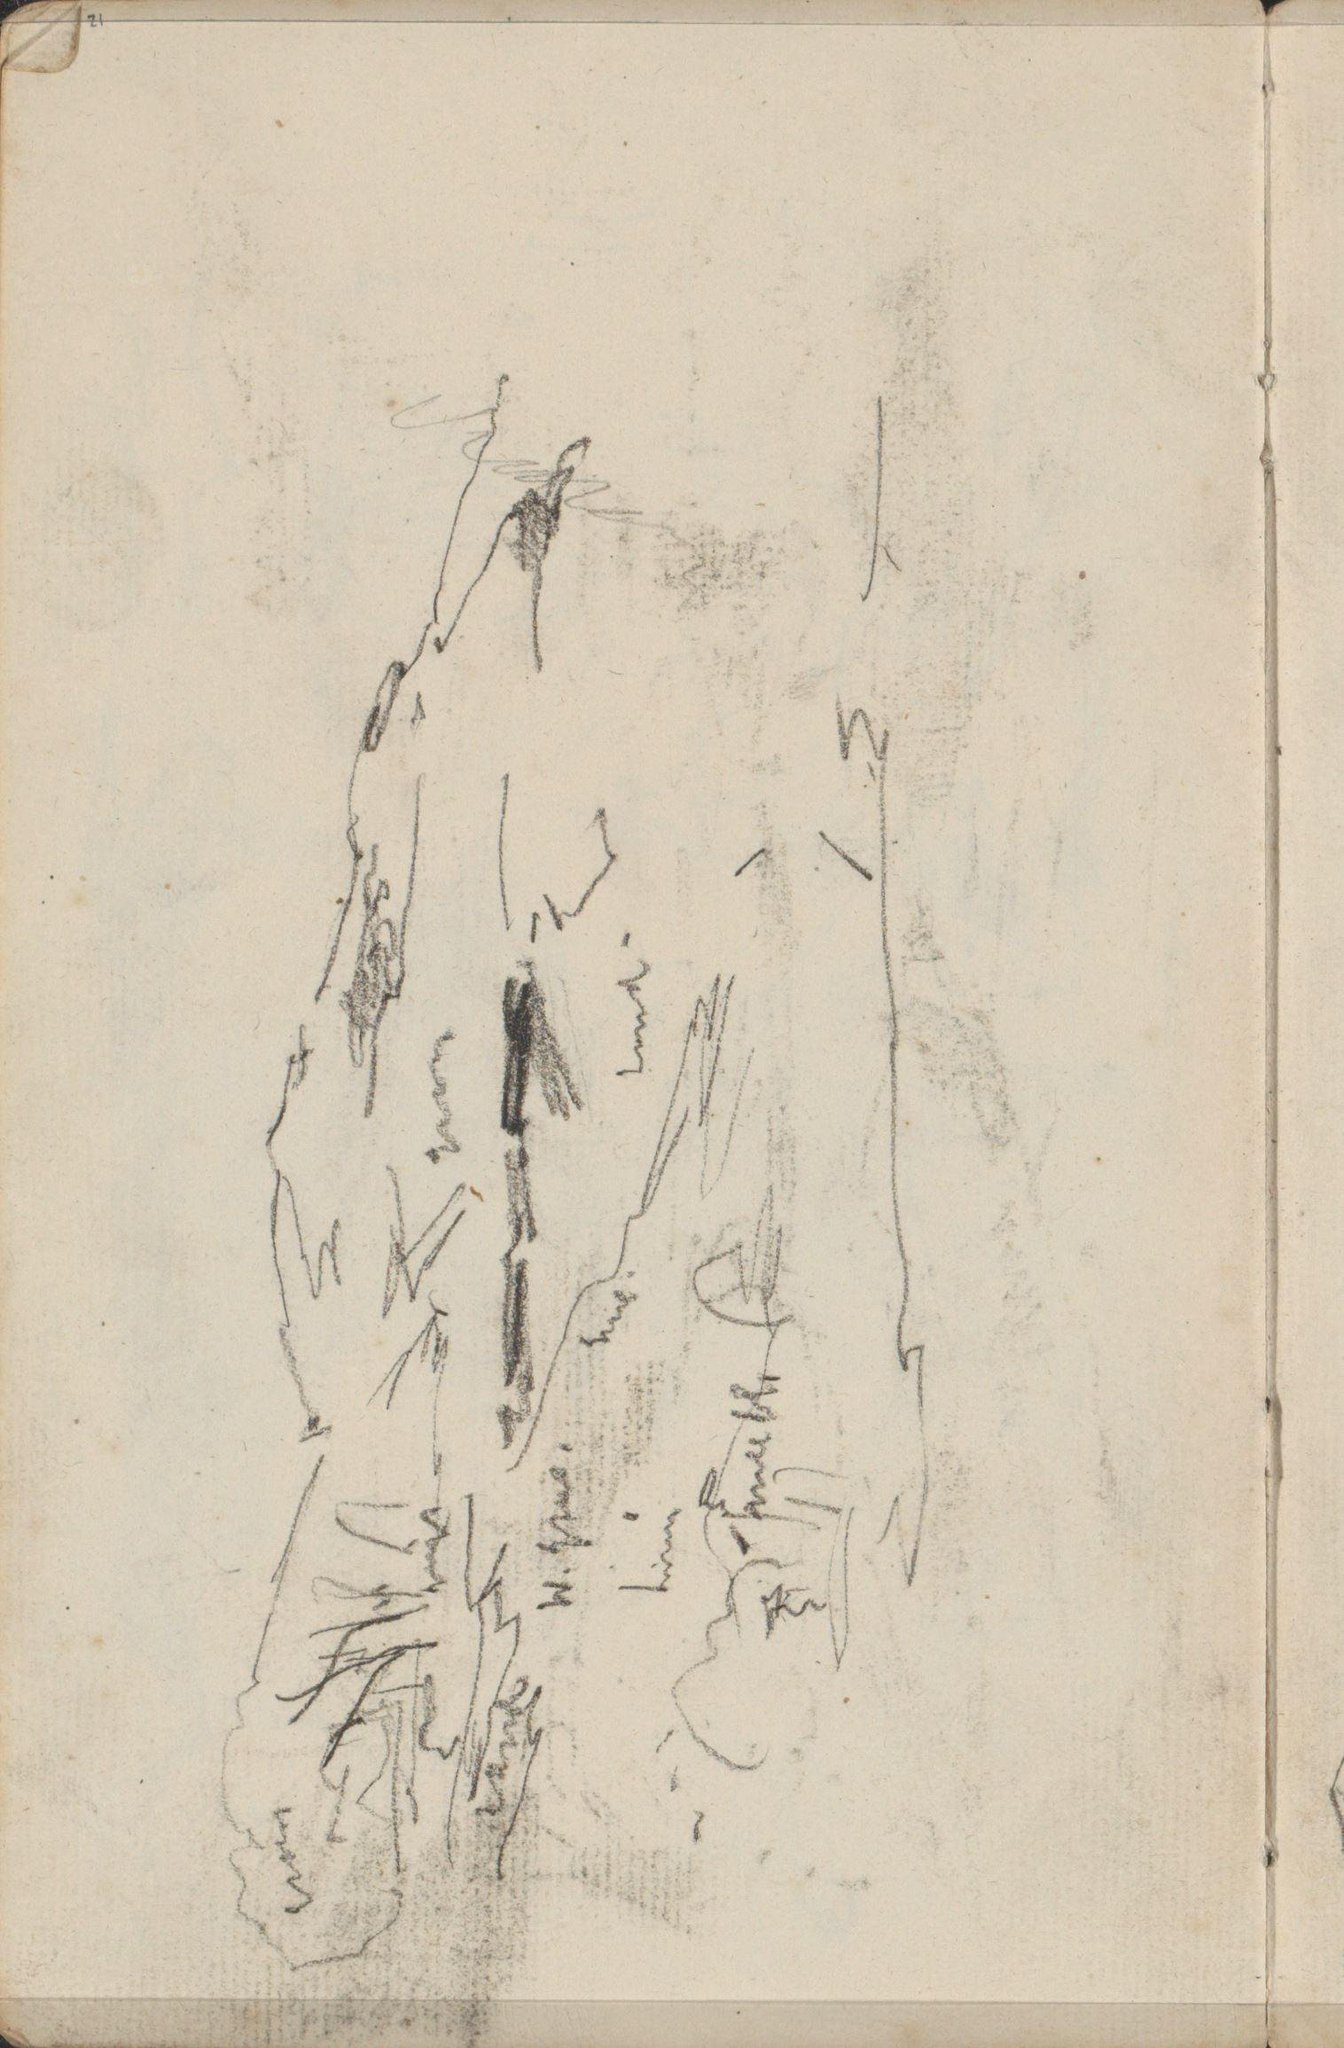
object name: sketchbook leaf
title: Duinlandschap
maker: george hendrik breitner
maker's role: draughtsman, painter, print maker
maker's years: 1857-1923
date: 1880-1882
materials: chalk, paper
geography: the hague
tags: dunes (sea not visible); in the dunes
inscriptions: kleurnotitie, handgeschreven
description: Pagina 21 uit een schetsboek met 23 bladen.